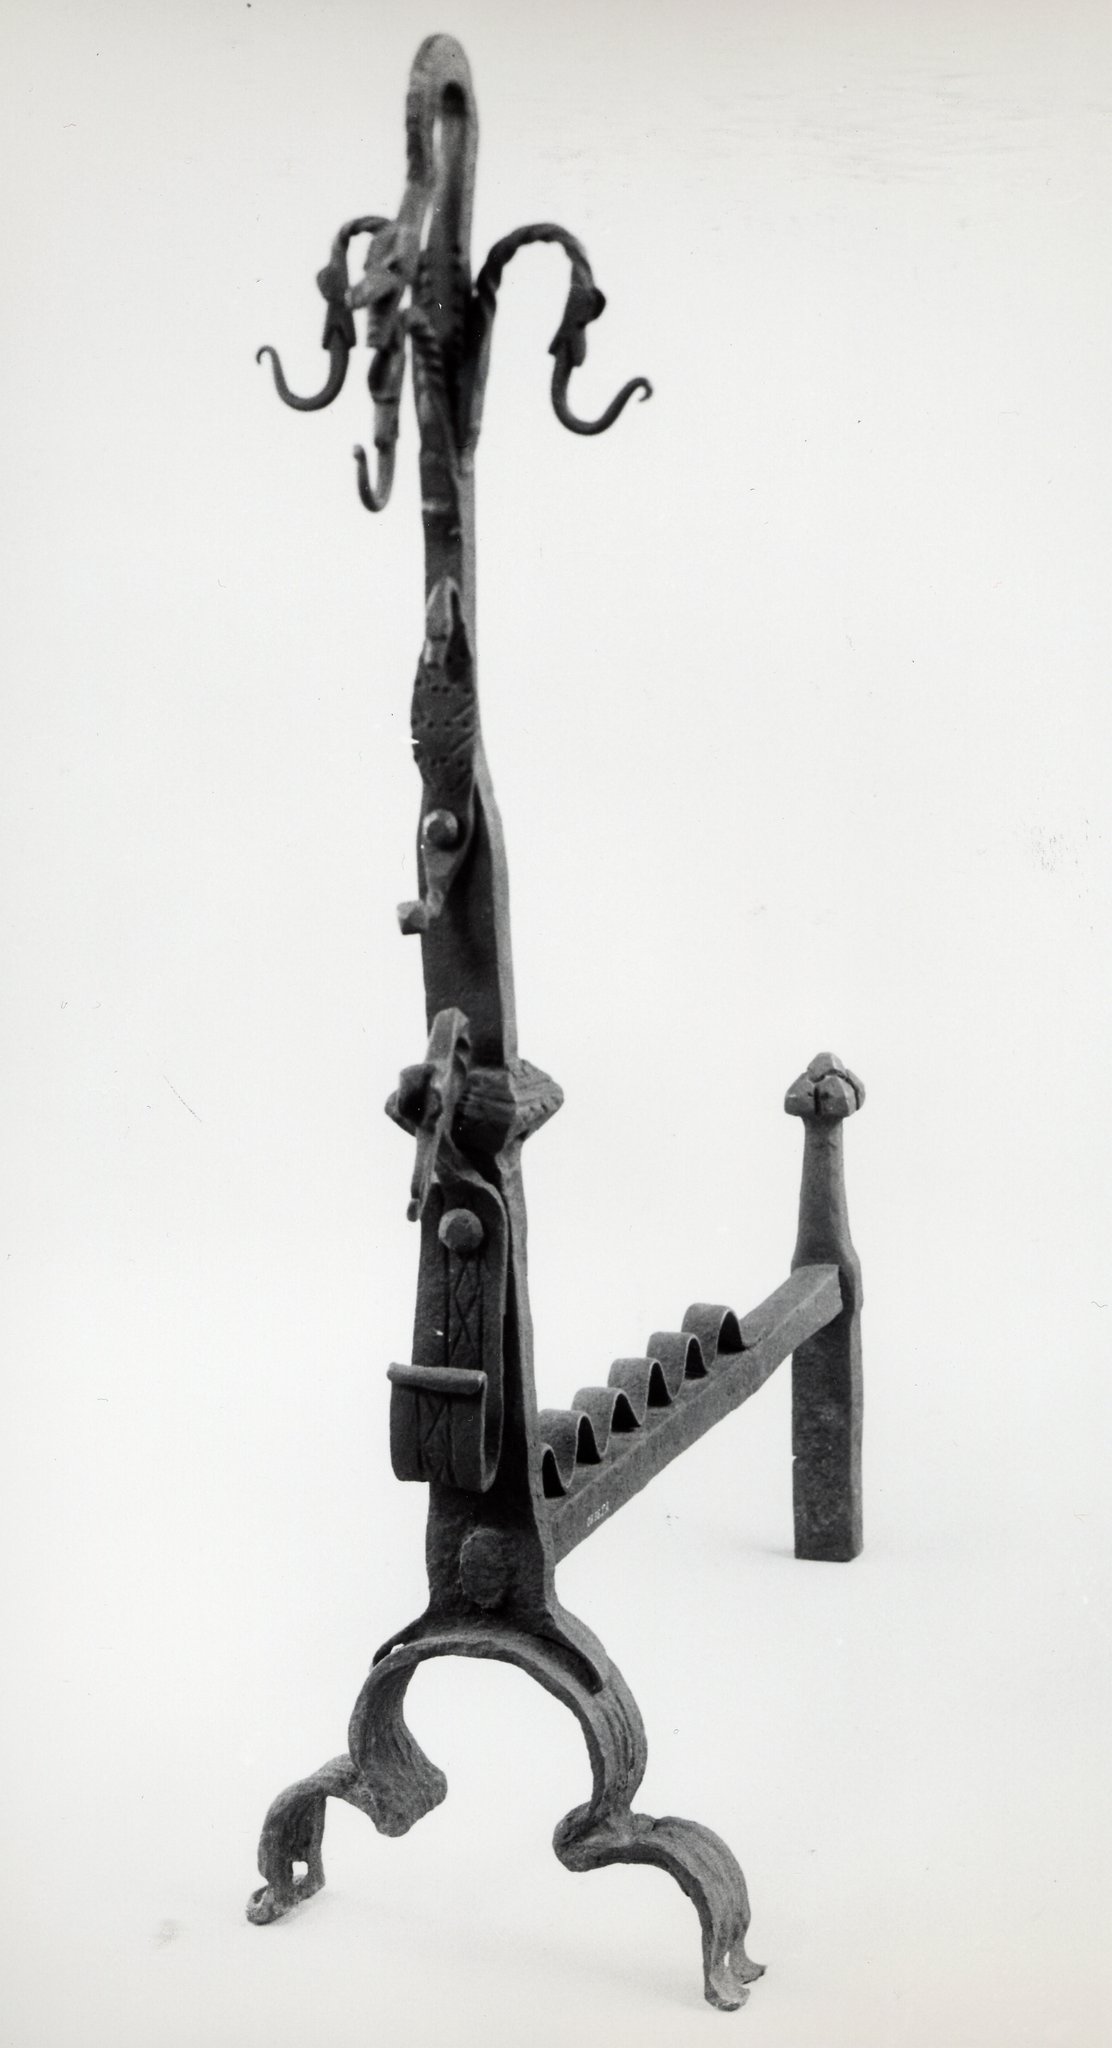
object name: andiron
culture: italian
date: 1301-1400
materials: iron